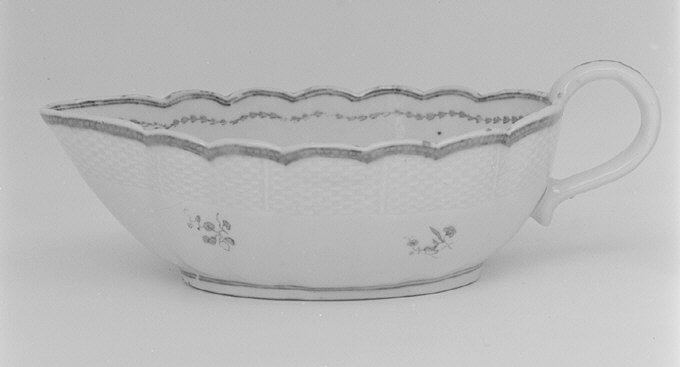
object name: sauceboat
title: Sauceboat (part of a service)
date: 1770-1785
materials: hard paste porcelain